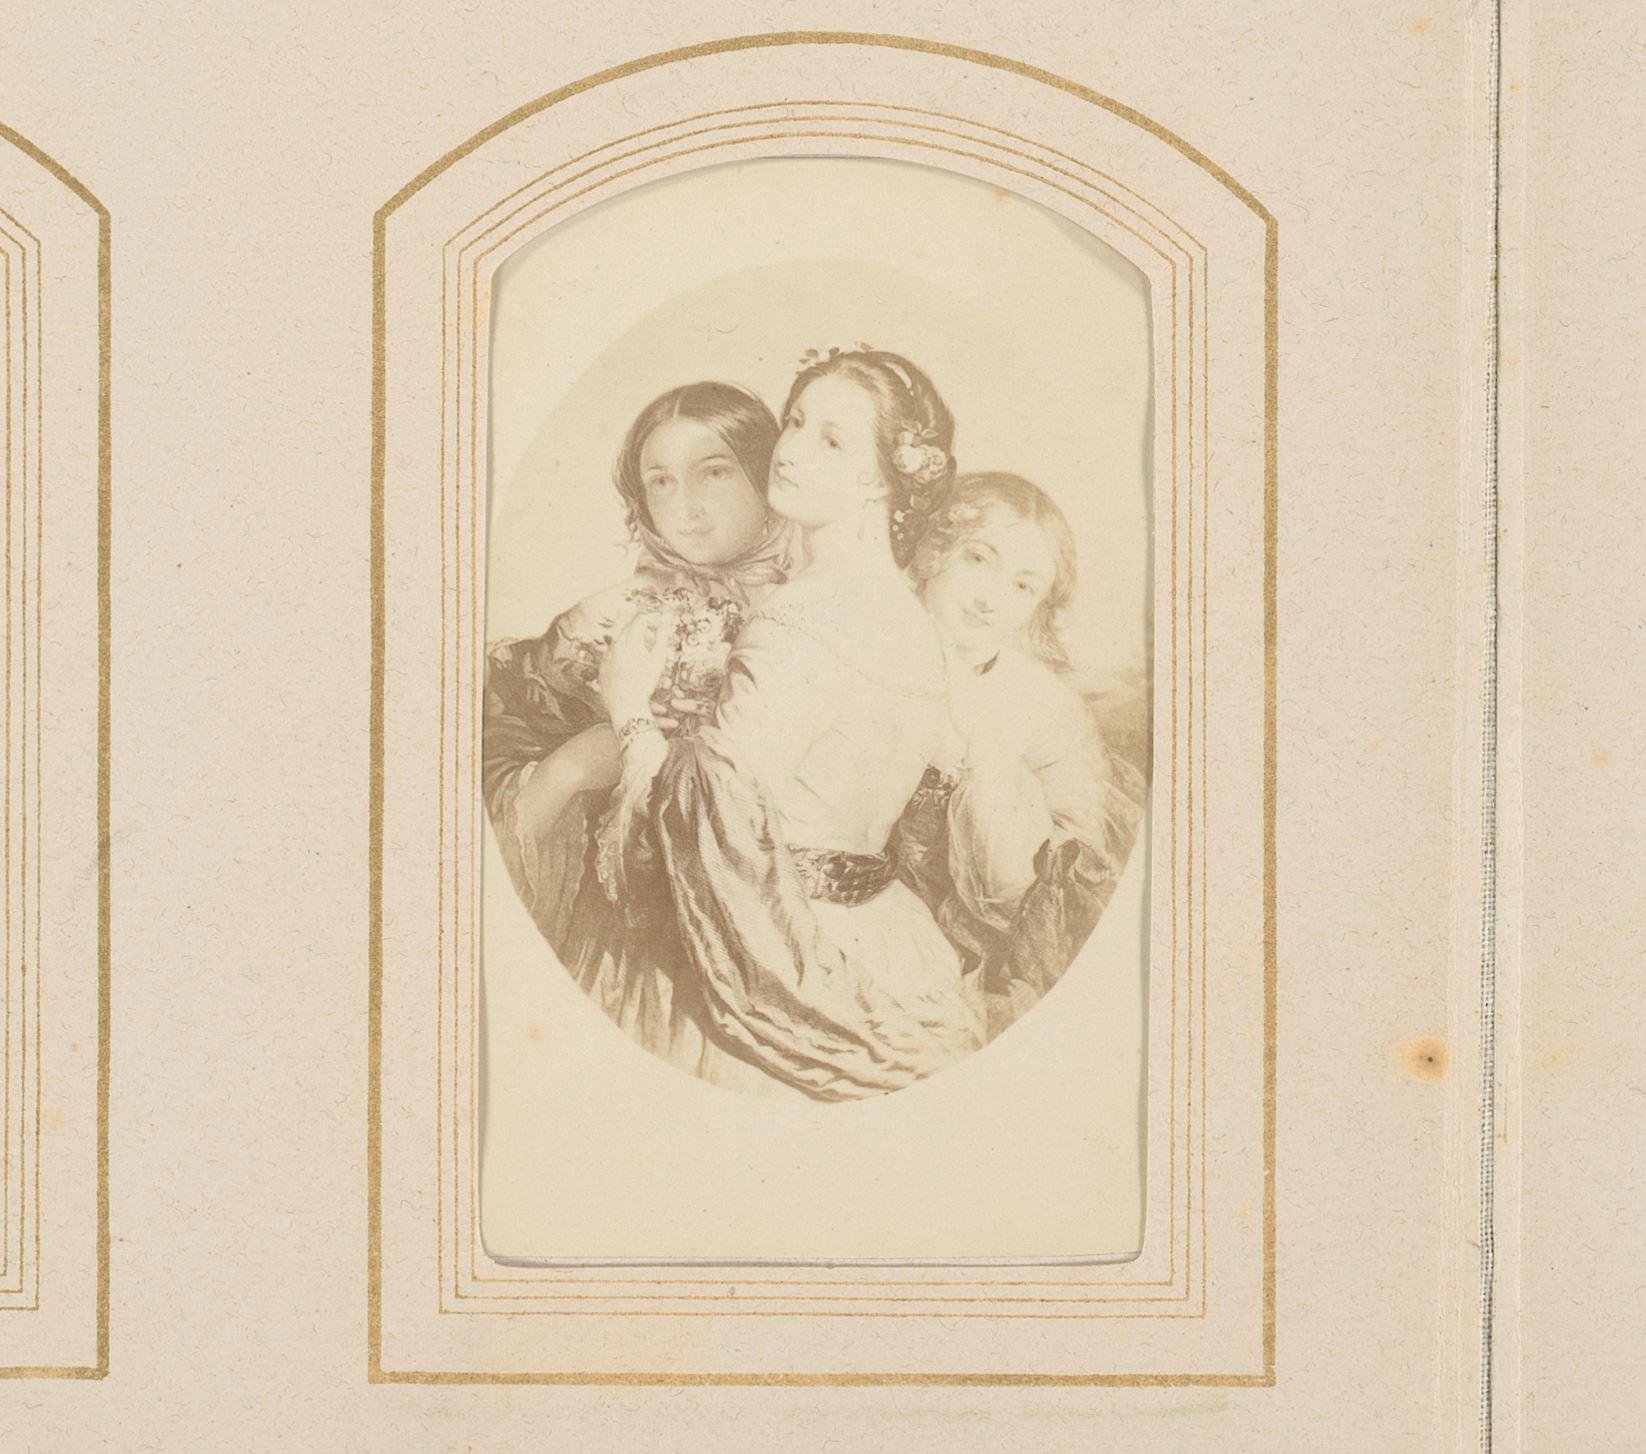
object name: carte de visite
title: Fotoreproductie van Das Schonheitsbouquet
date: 1870-1890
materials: cardboard, photographic support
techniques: albumen print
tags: adolescent, young woman, maiden, painting, drawing and the graphic arts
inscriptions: annotation: ‘Schönheitsbouquet’, number: ‘1484’